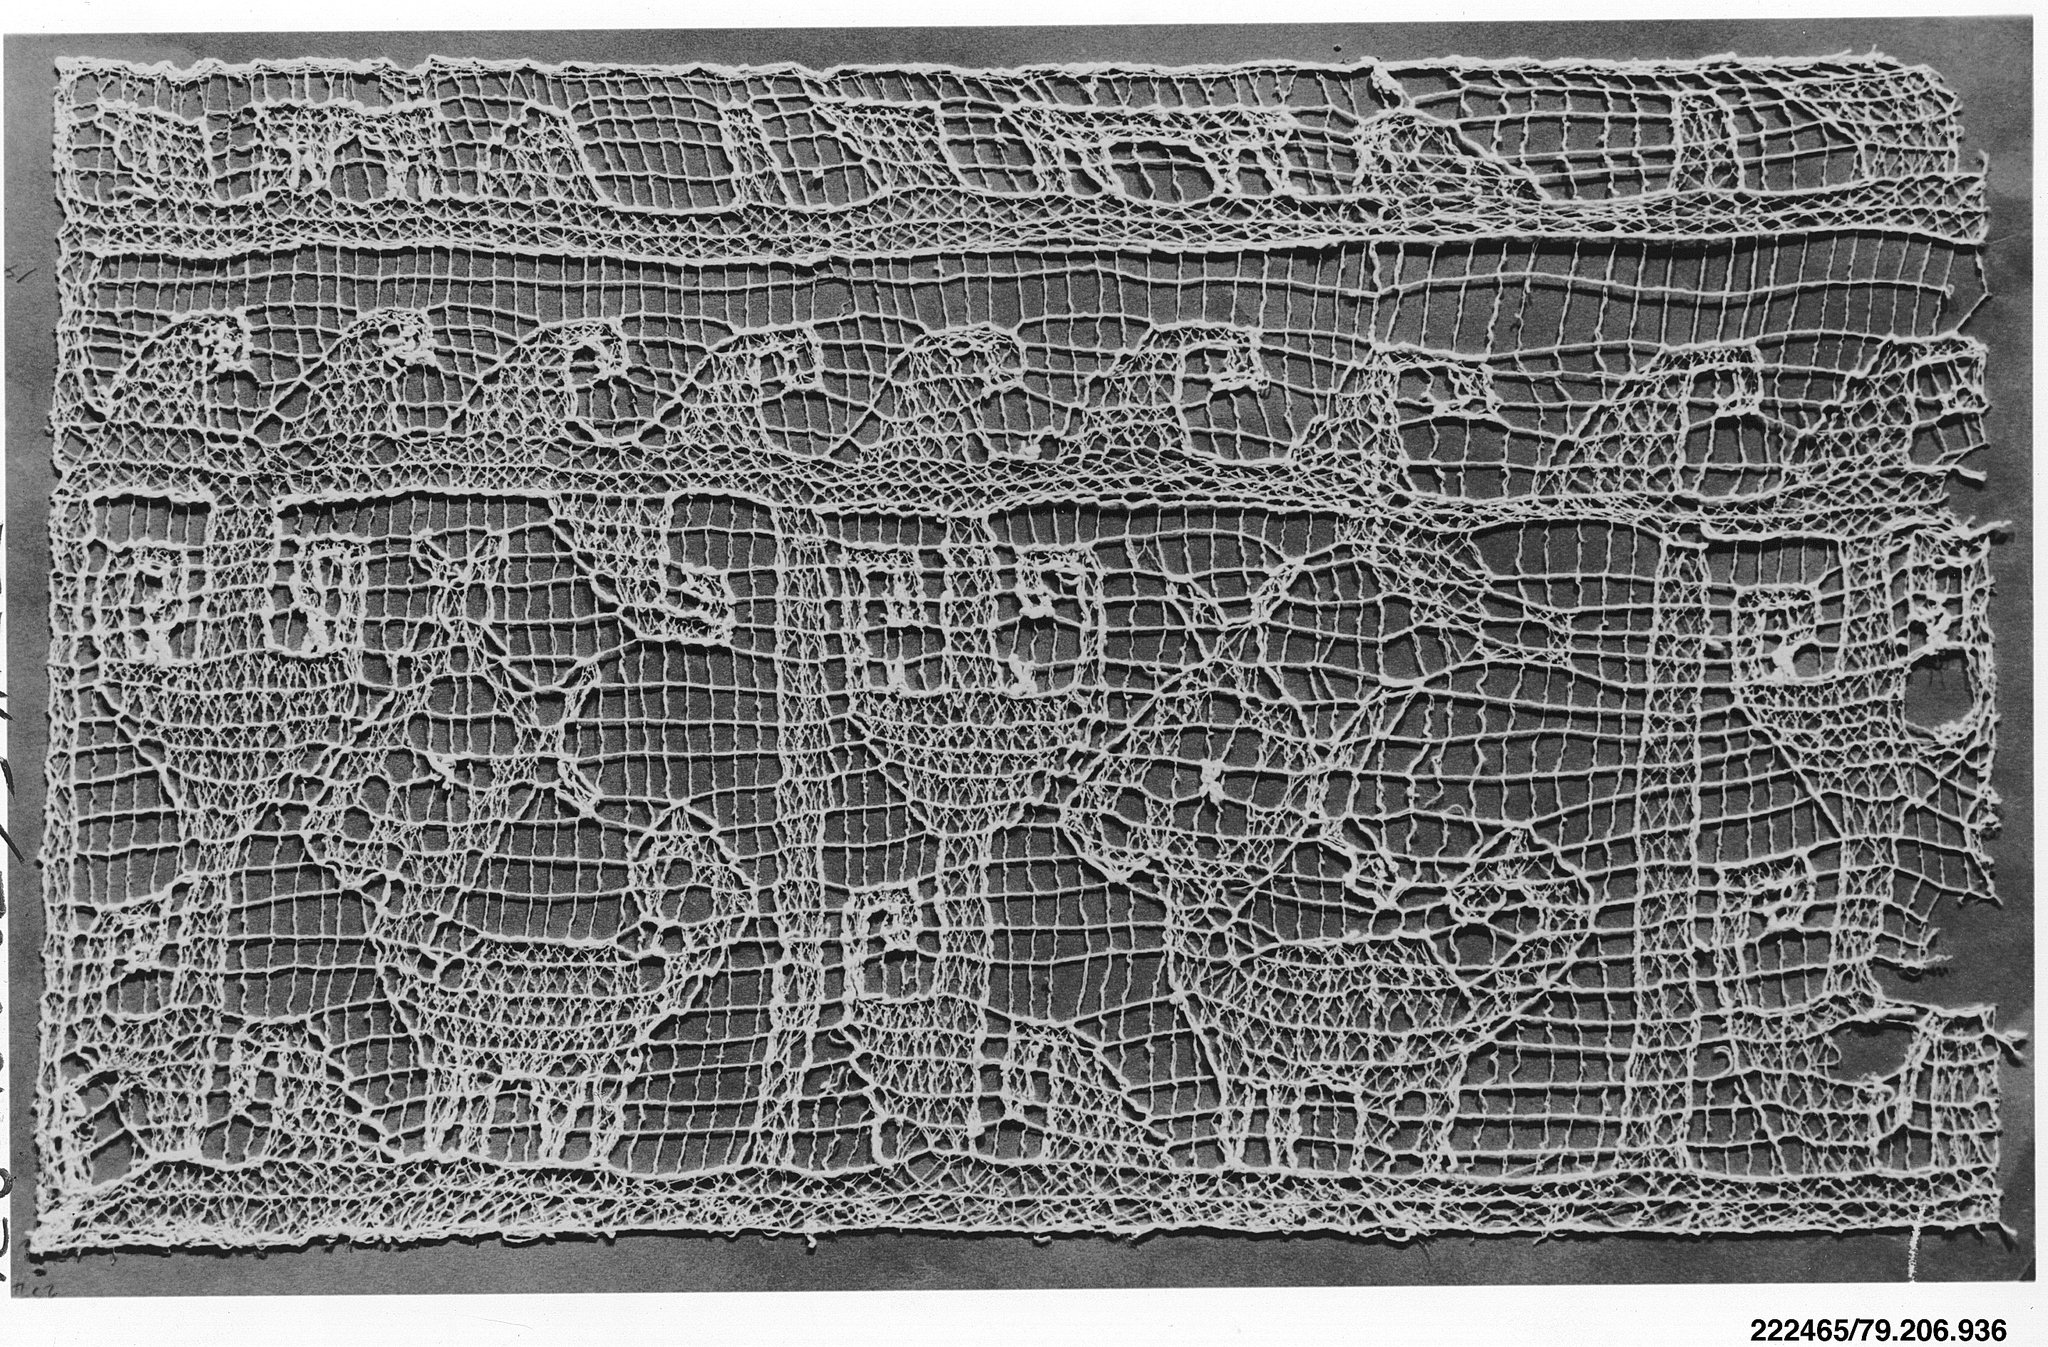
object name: headband fragment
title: Openwork Headband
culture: chancay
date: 1101-1500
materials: cotton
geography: peru